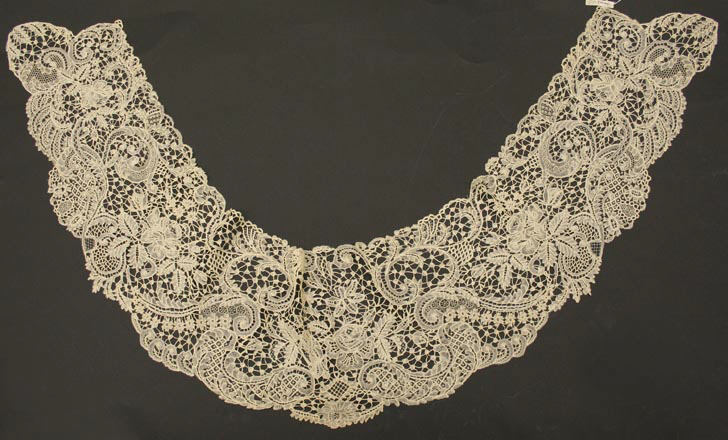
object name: collar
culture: british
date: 1801-1900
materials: linen